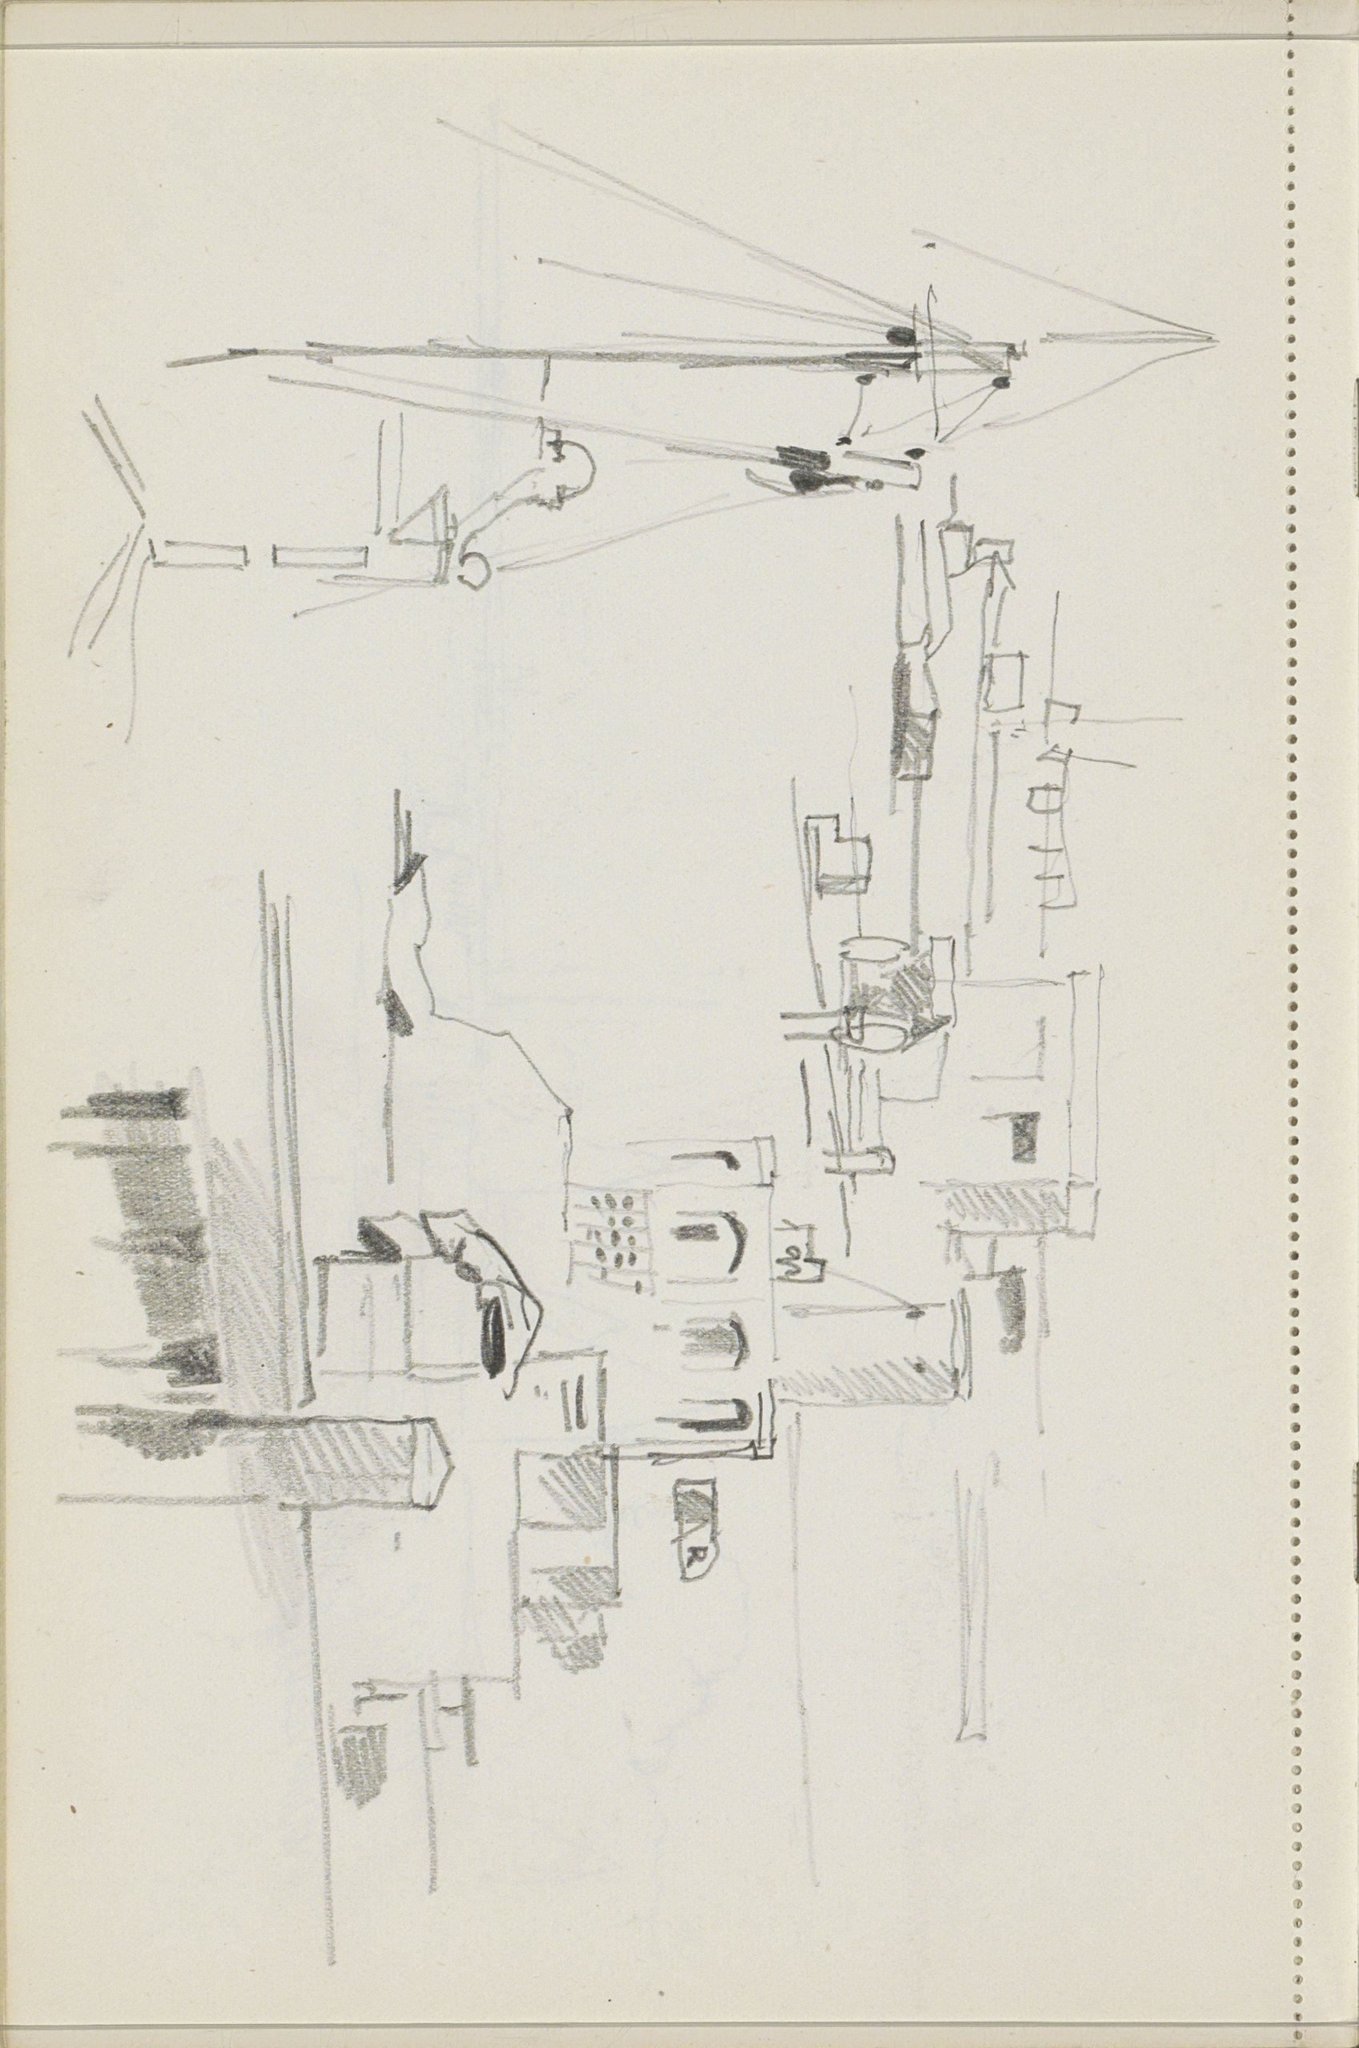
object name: sketchbook leaf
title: Mast van een zeilschip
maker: cornelis vreedenburgh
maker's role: draughtsman, print maker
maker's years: 1880-1946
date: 1890-1946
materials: paper, pencil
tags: architecture, parts of ship's exterior: mast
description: Tevens architectuurstudies. Blad 18 verso uit een schetsboek met uit 75 bladen.